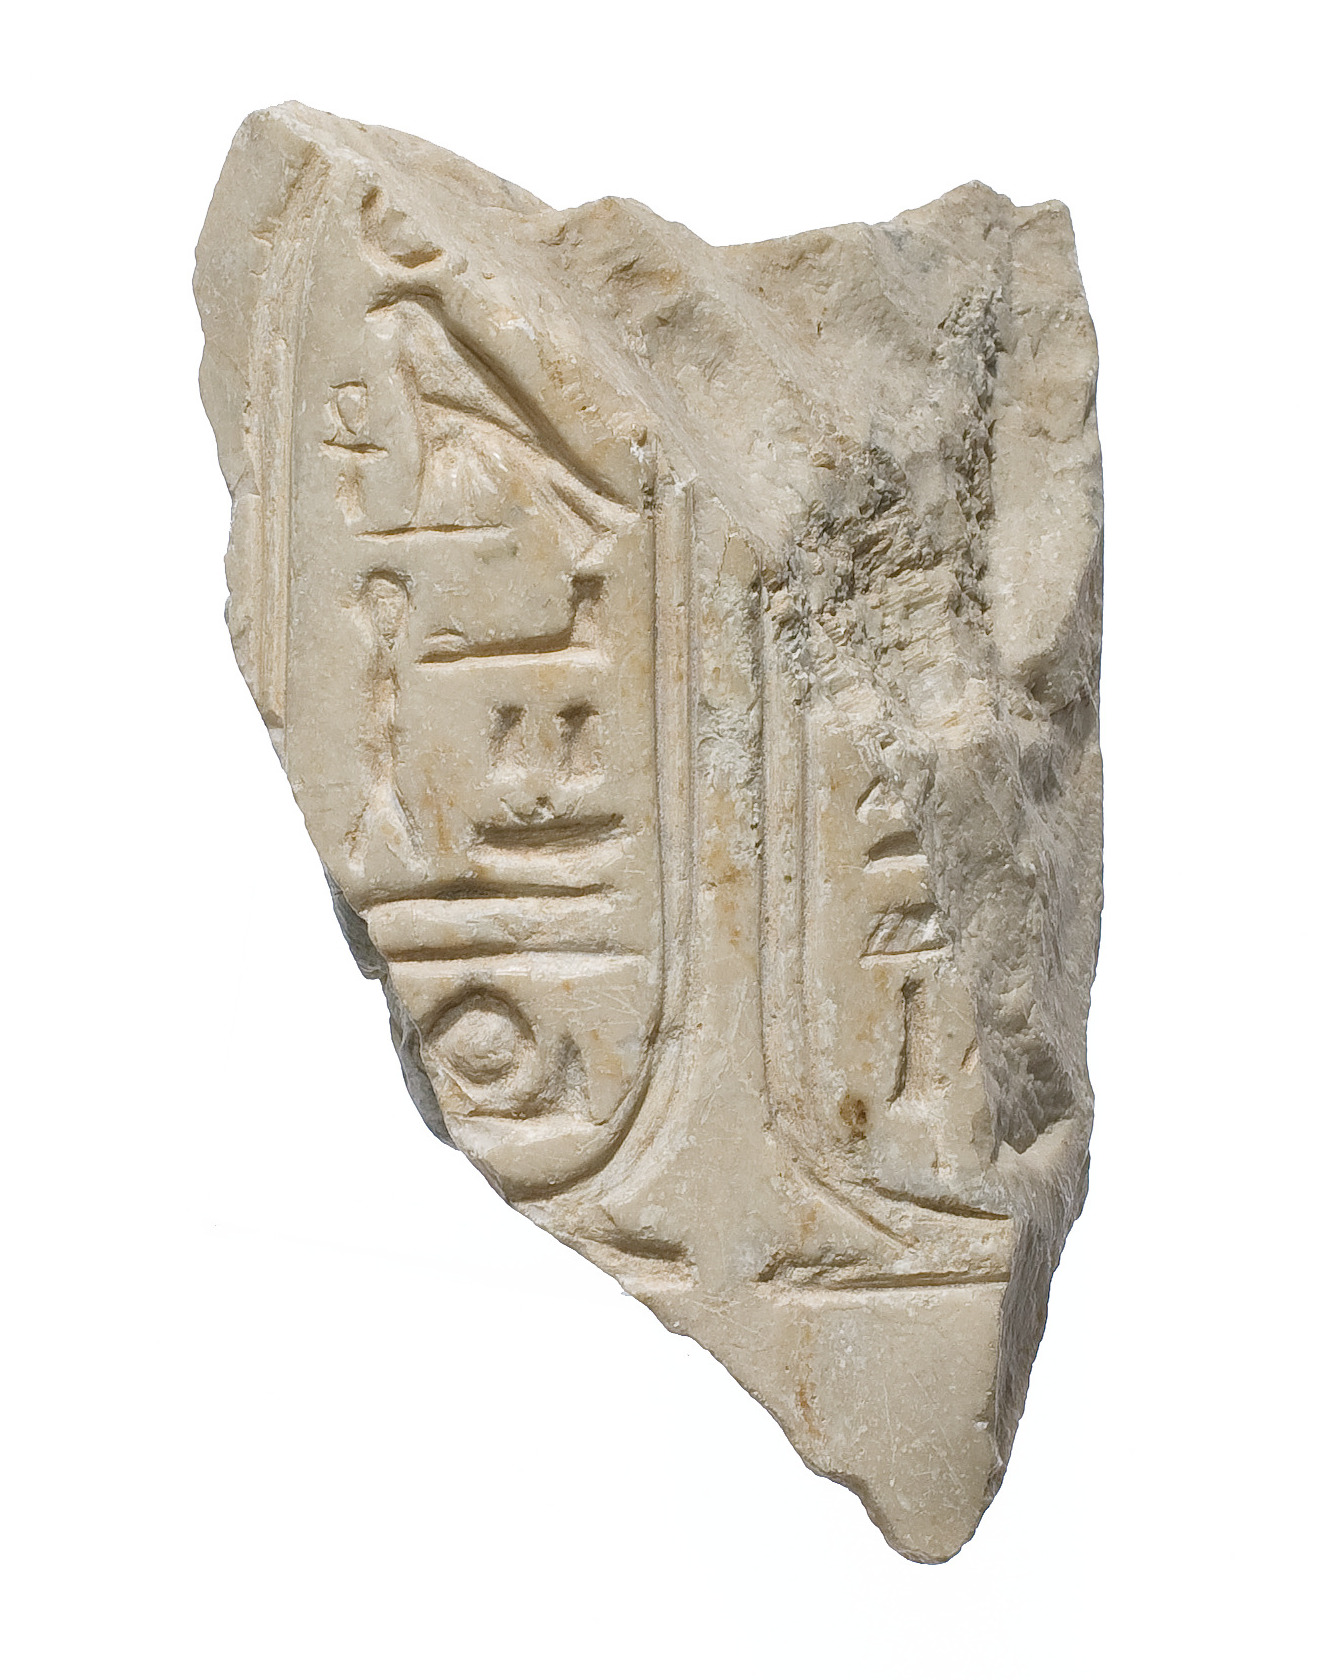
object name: arm at wrist, aten cartouch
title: Arm at wrist, Aten cartouches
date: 1353-1336 BCE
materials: limestone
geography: egypt